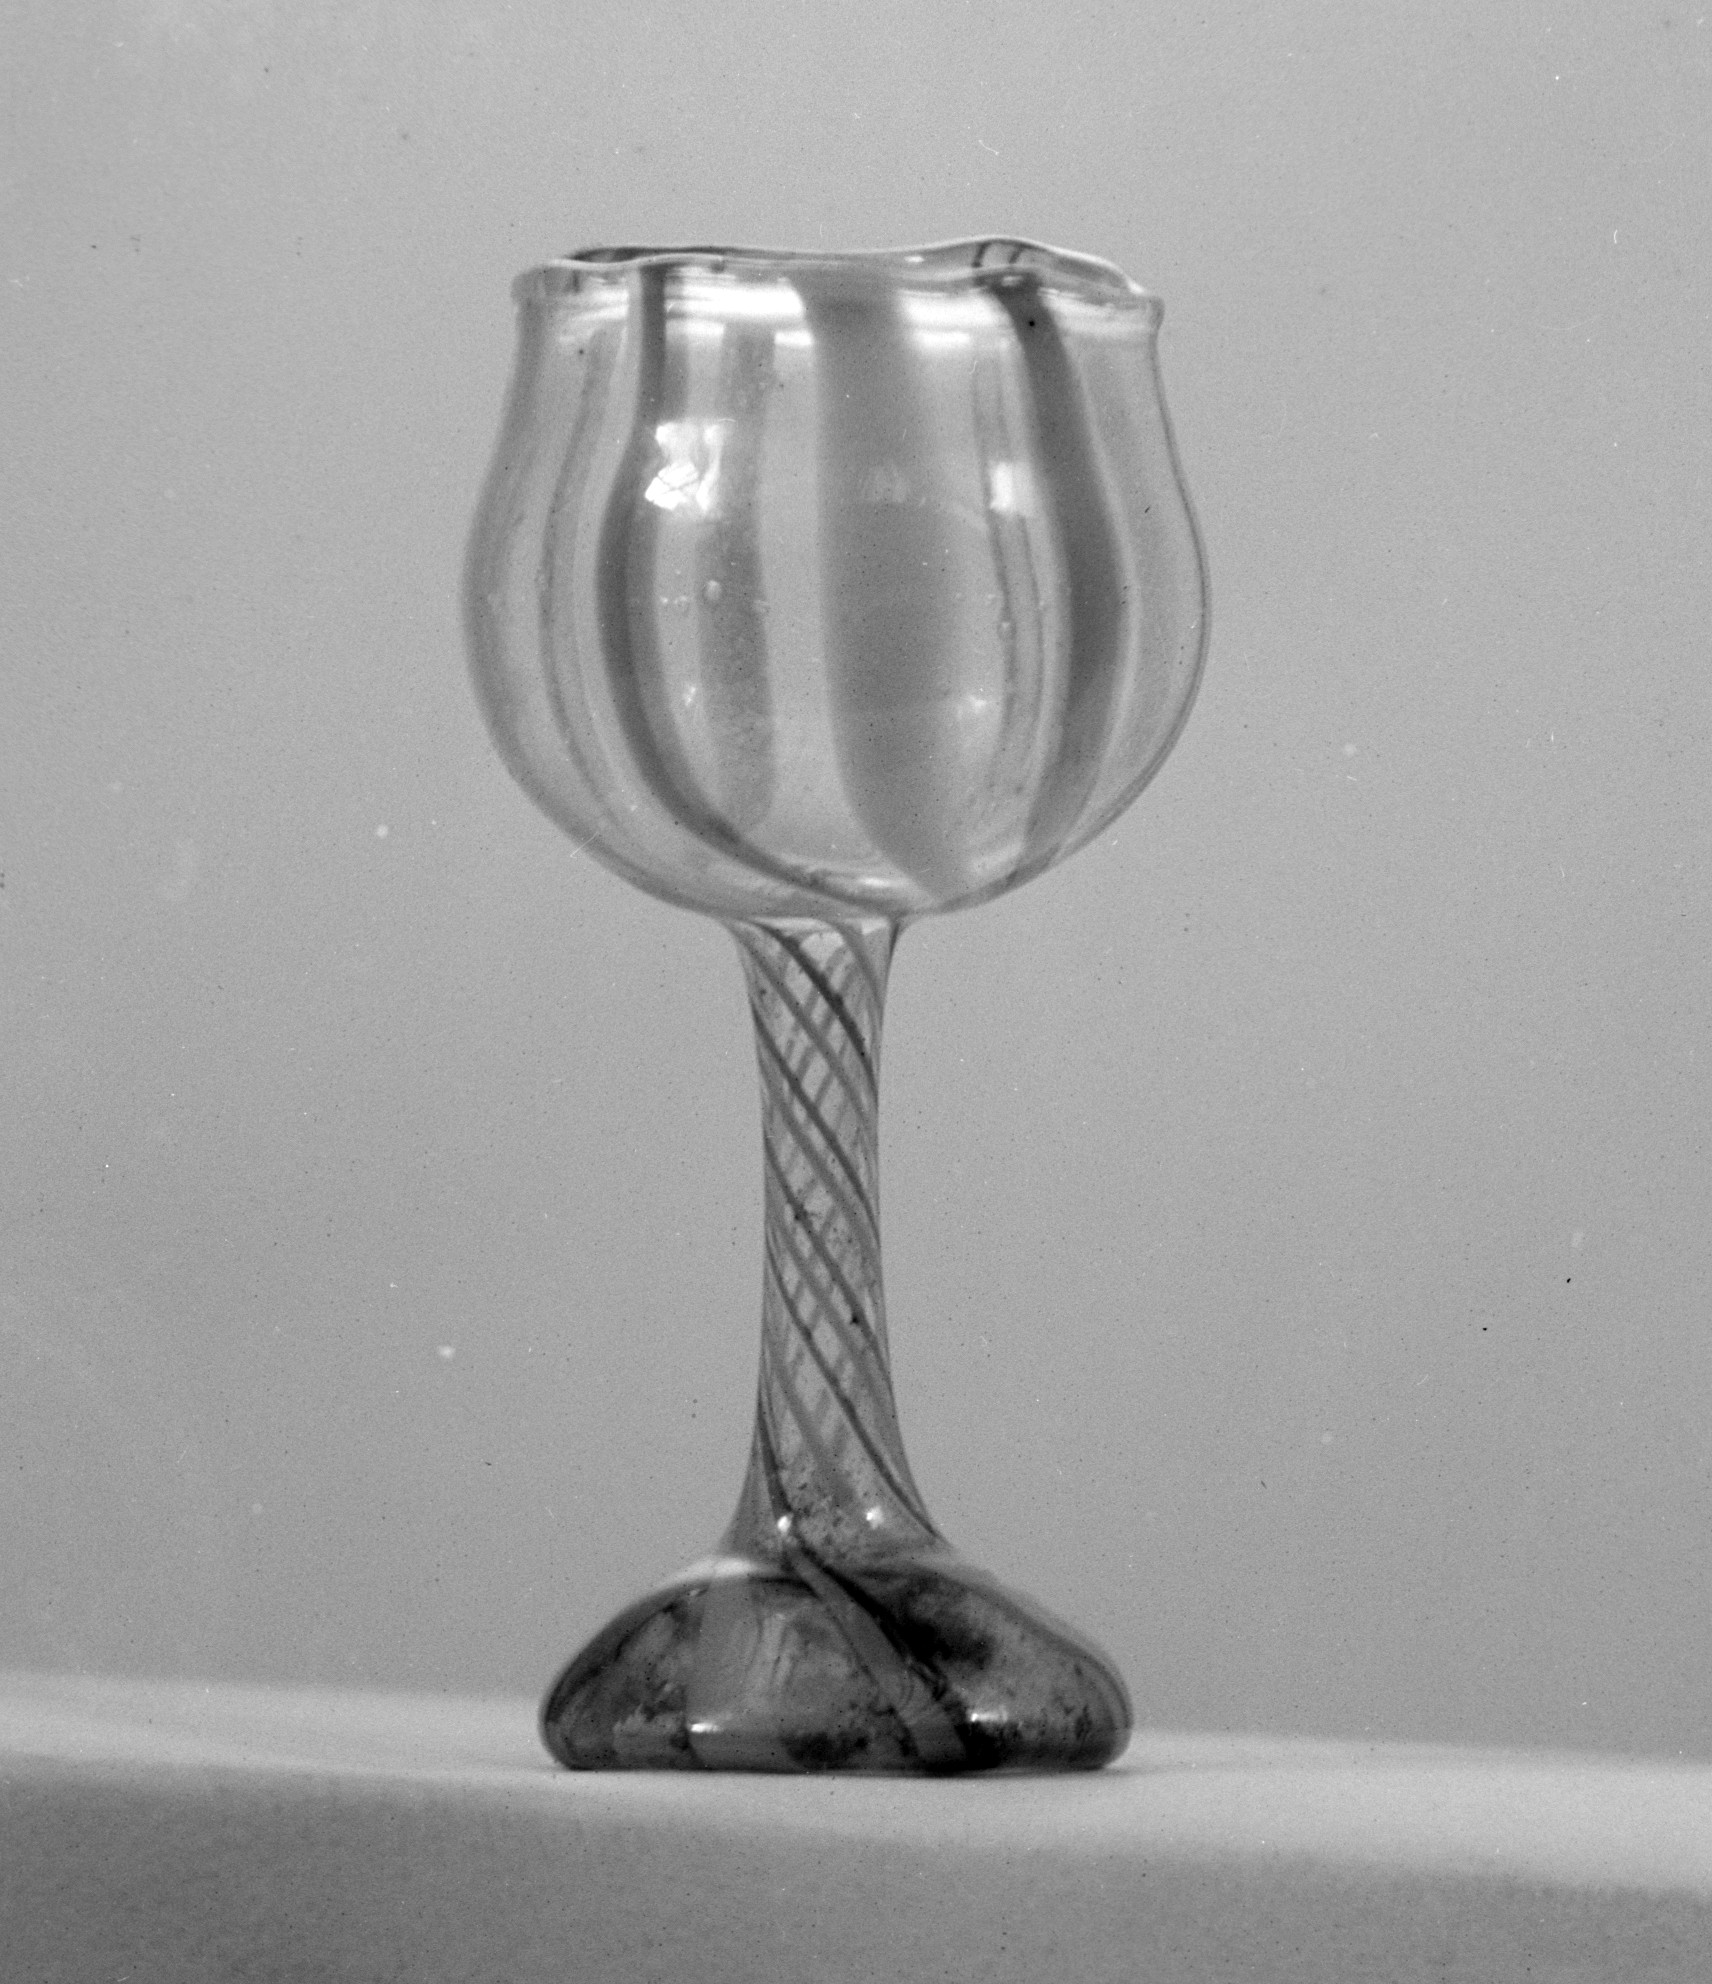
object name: goblet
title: Miniature goblet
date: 1801-1833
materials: glass